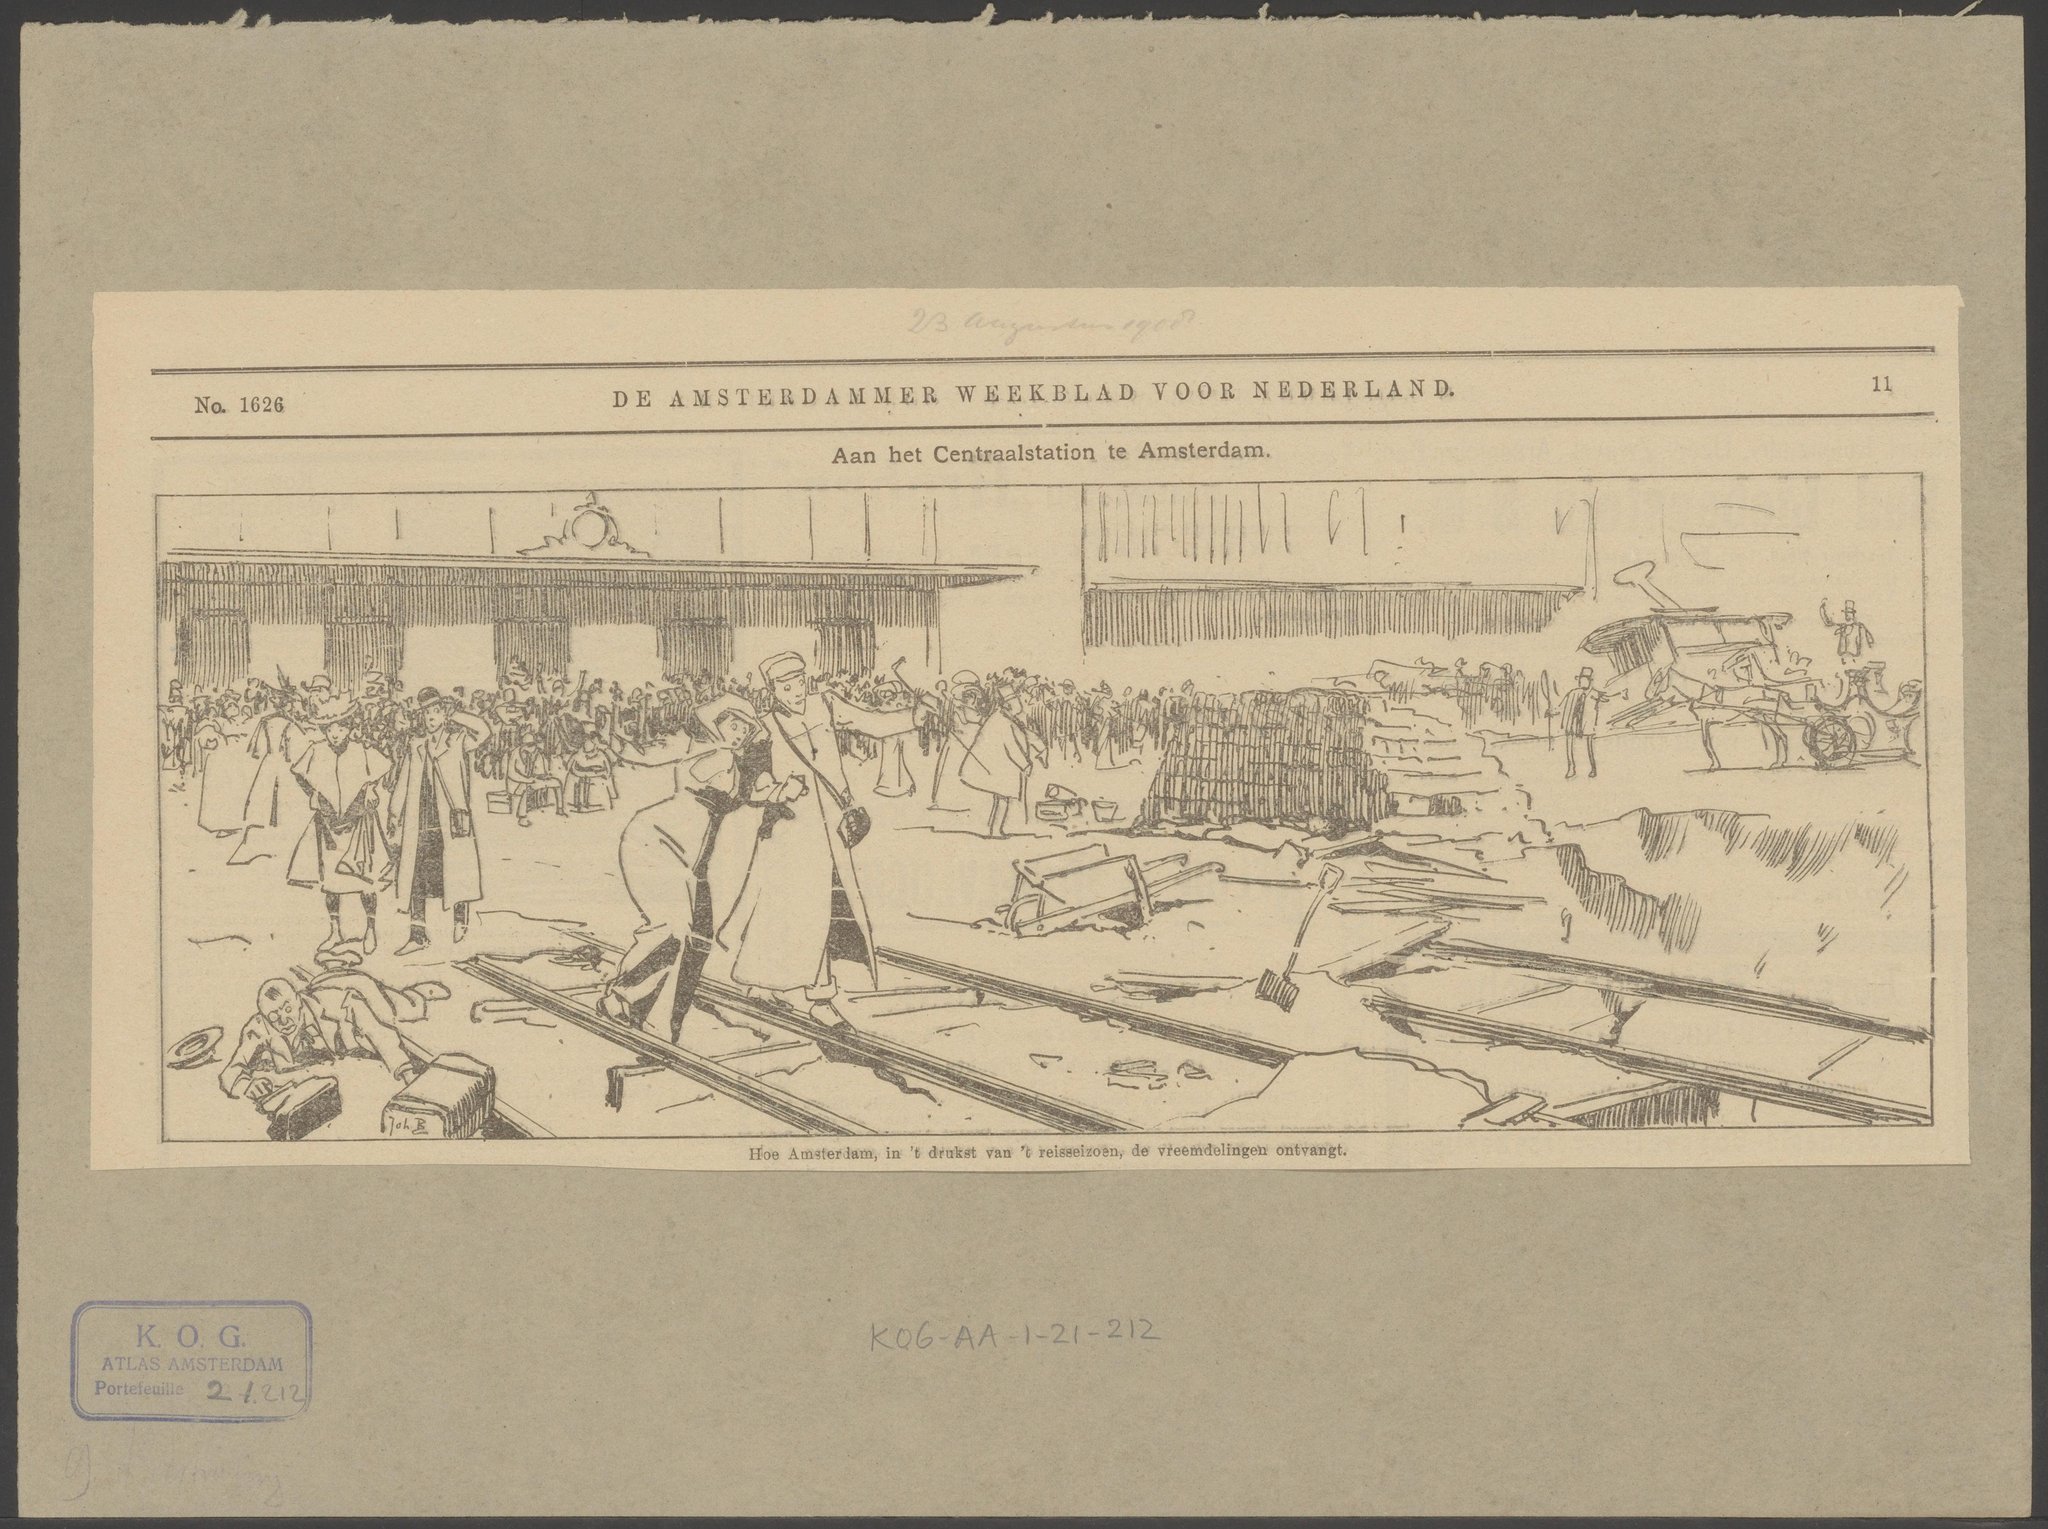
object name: photomechanical print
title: Aan het Centraalstation te Amsterdam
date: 1908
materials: paper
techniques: letterpress printing, line block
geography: amsterdam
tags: square, place, circus, etc., station; shelter (railway, tramway)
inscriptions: collector's mark: Lugt 1641b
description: Prent uit: De Amsterdammer 32 (1908), nr. 1626, 23 augustus 1908, p. 11.